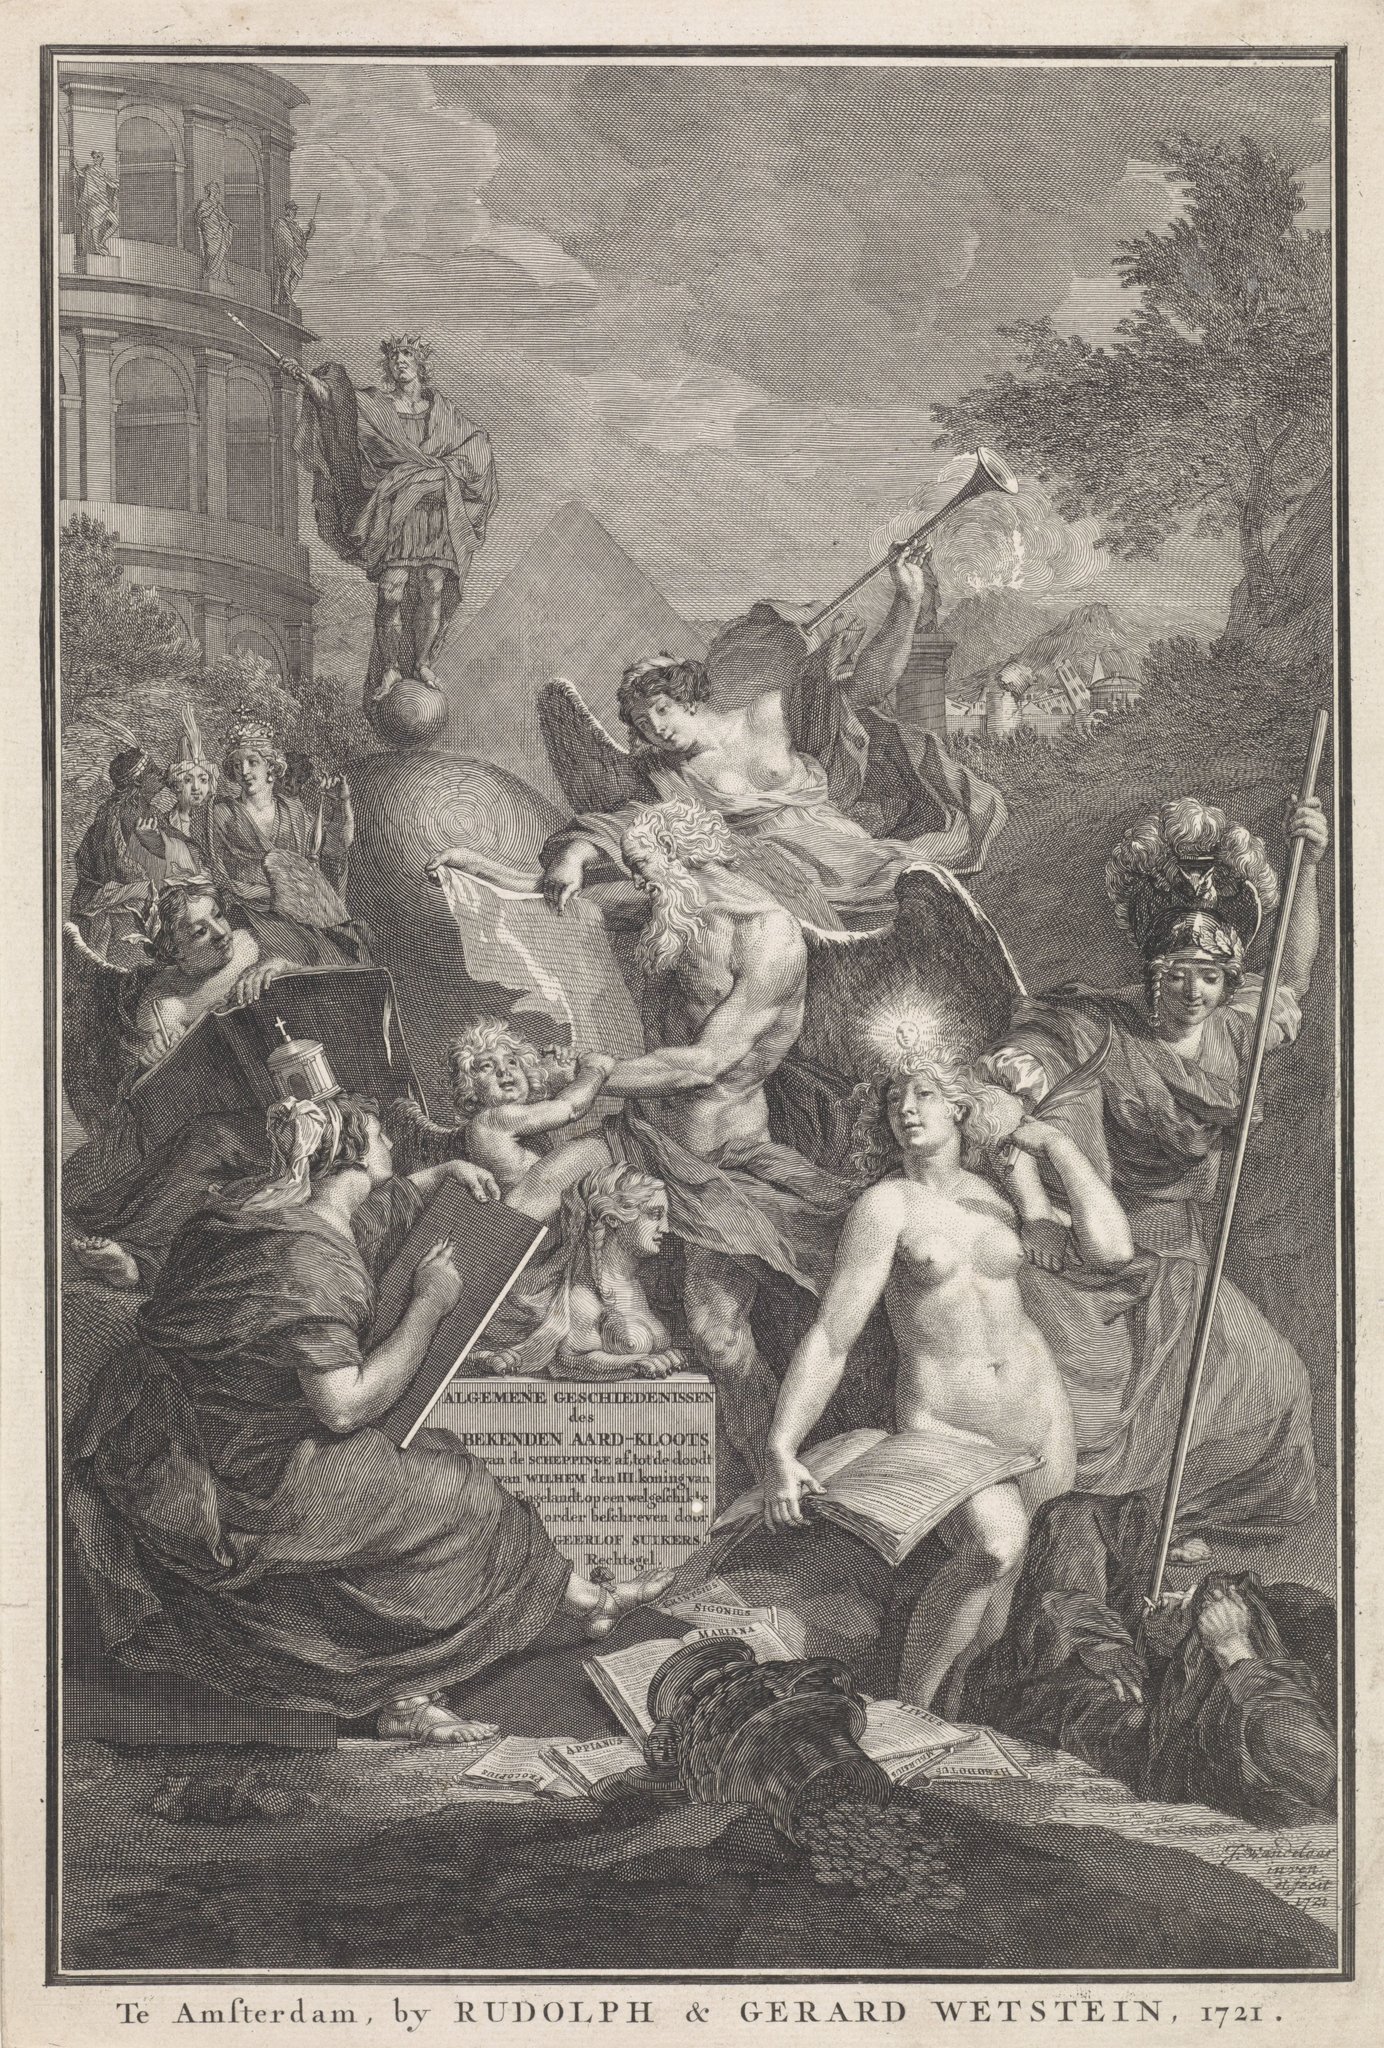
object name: titelblad, titelpagina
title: Titelpagina voor: G. Suikers, Algemene kerkelyke en wereldlyke geschiedenissen des bekenden aard-kloots, 1721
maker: jan wandelaar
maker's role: draughtsman, print maker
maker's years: 1690-1759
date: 1721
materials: paper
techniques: engraving, etching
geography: amsterdam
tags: sphinx (lion/woman); 'sfinge' (ripa), (story of) minerva (pallas, athena), truth; 'verità' (ripa), 'historia'; 'historia' (ripa), fame; 'fama', 'fama buona', 'fama chiara' (ripa), father time, man with wings and scythe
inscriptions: collector's mark: Lugt 2228, collector's mark: Lugt 2760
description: Menigte allegorische figuren rond een sfinx op een sokkel. Links Geschiedenis en een schrijvende vrouwelijke personificatie gekroond met een toren. Vader Tijd ontrolt een papier, in de lucht de Faam. Rechts de Waarheid: een naakte vrouw met een boek en de zon op haar hoofd. Achter haar Minerva, die met haar lans een duivelse figuur de aarde in duwt.